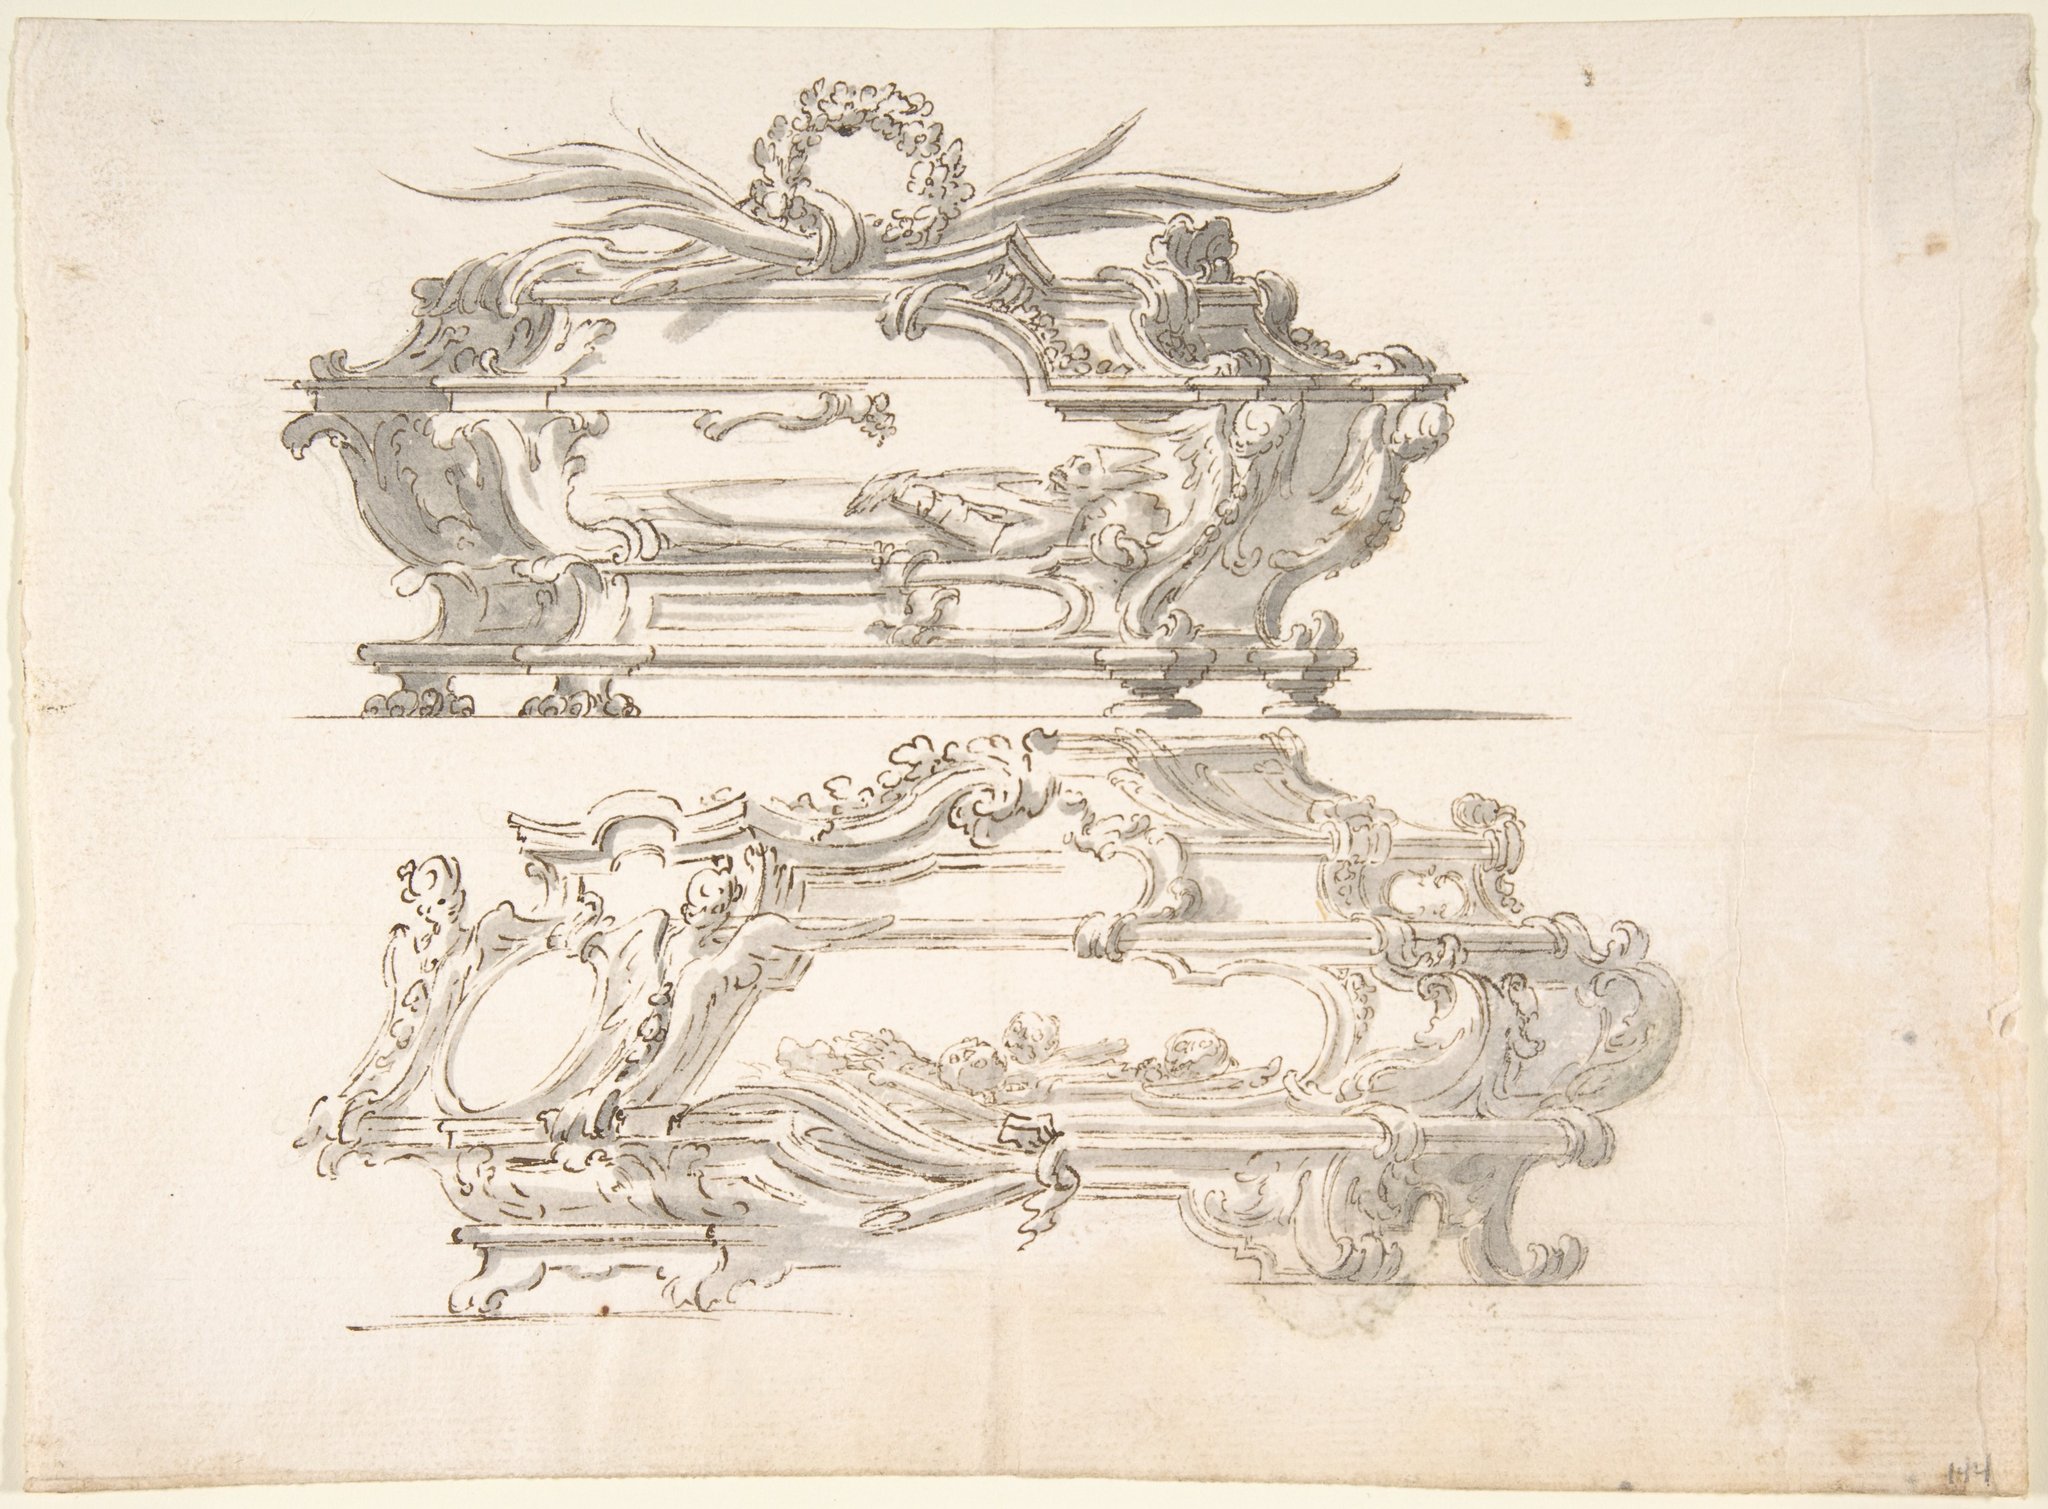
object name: drawing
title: Designs for Two Reliquary Caskets; at top Bishop; at bottom: Skulls and Bones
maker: anonymous, italian, piedmontese, 18th century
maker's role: artist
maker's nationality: italian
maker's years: 1700-1800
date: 1700-1780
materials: graphite, ink, lead, drawing material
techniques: brush, pen, wash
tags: skulls,bishops,reliquaries